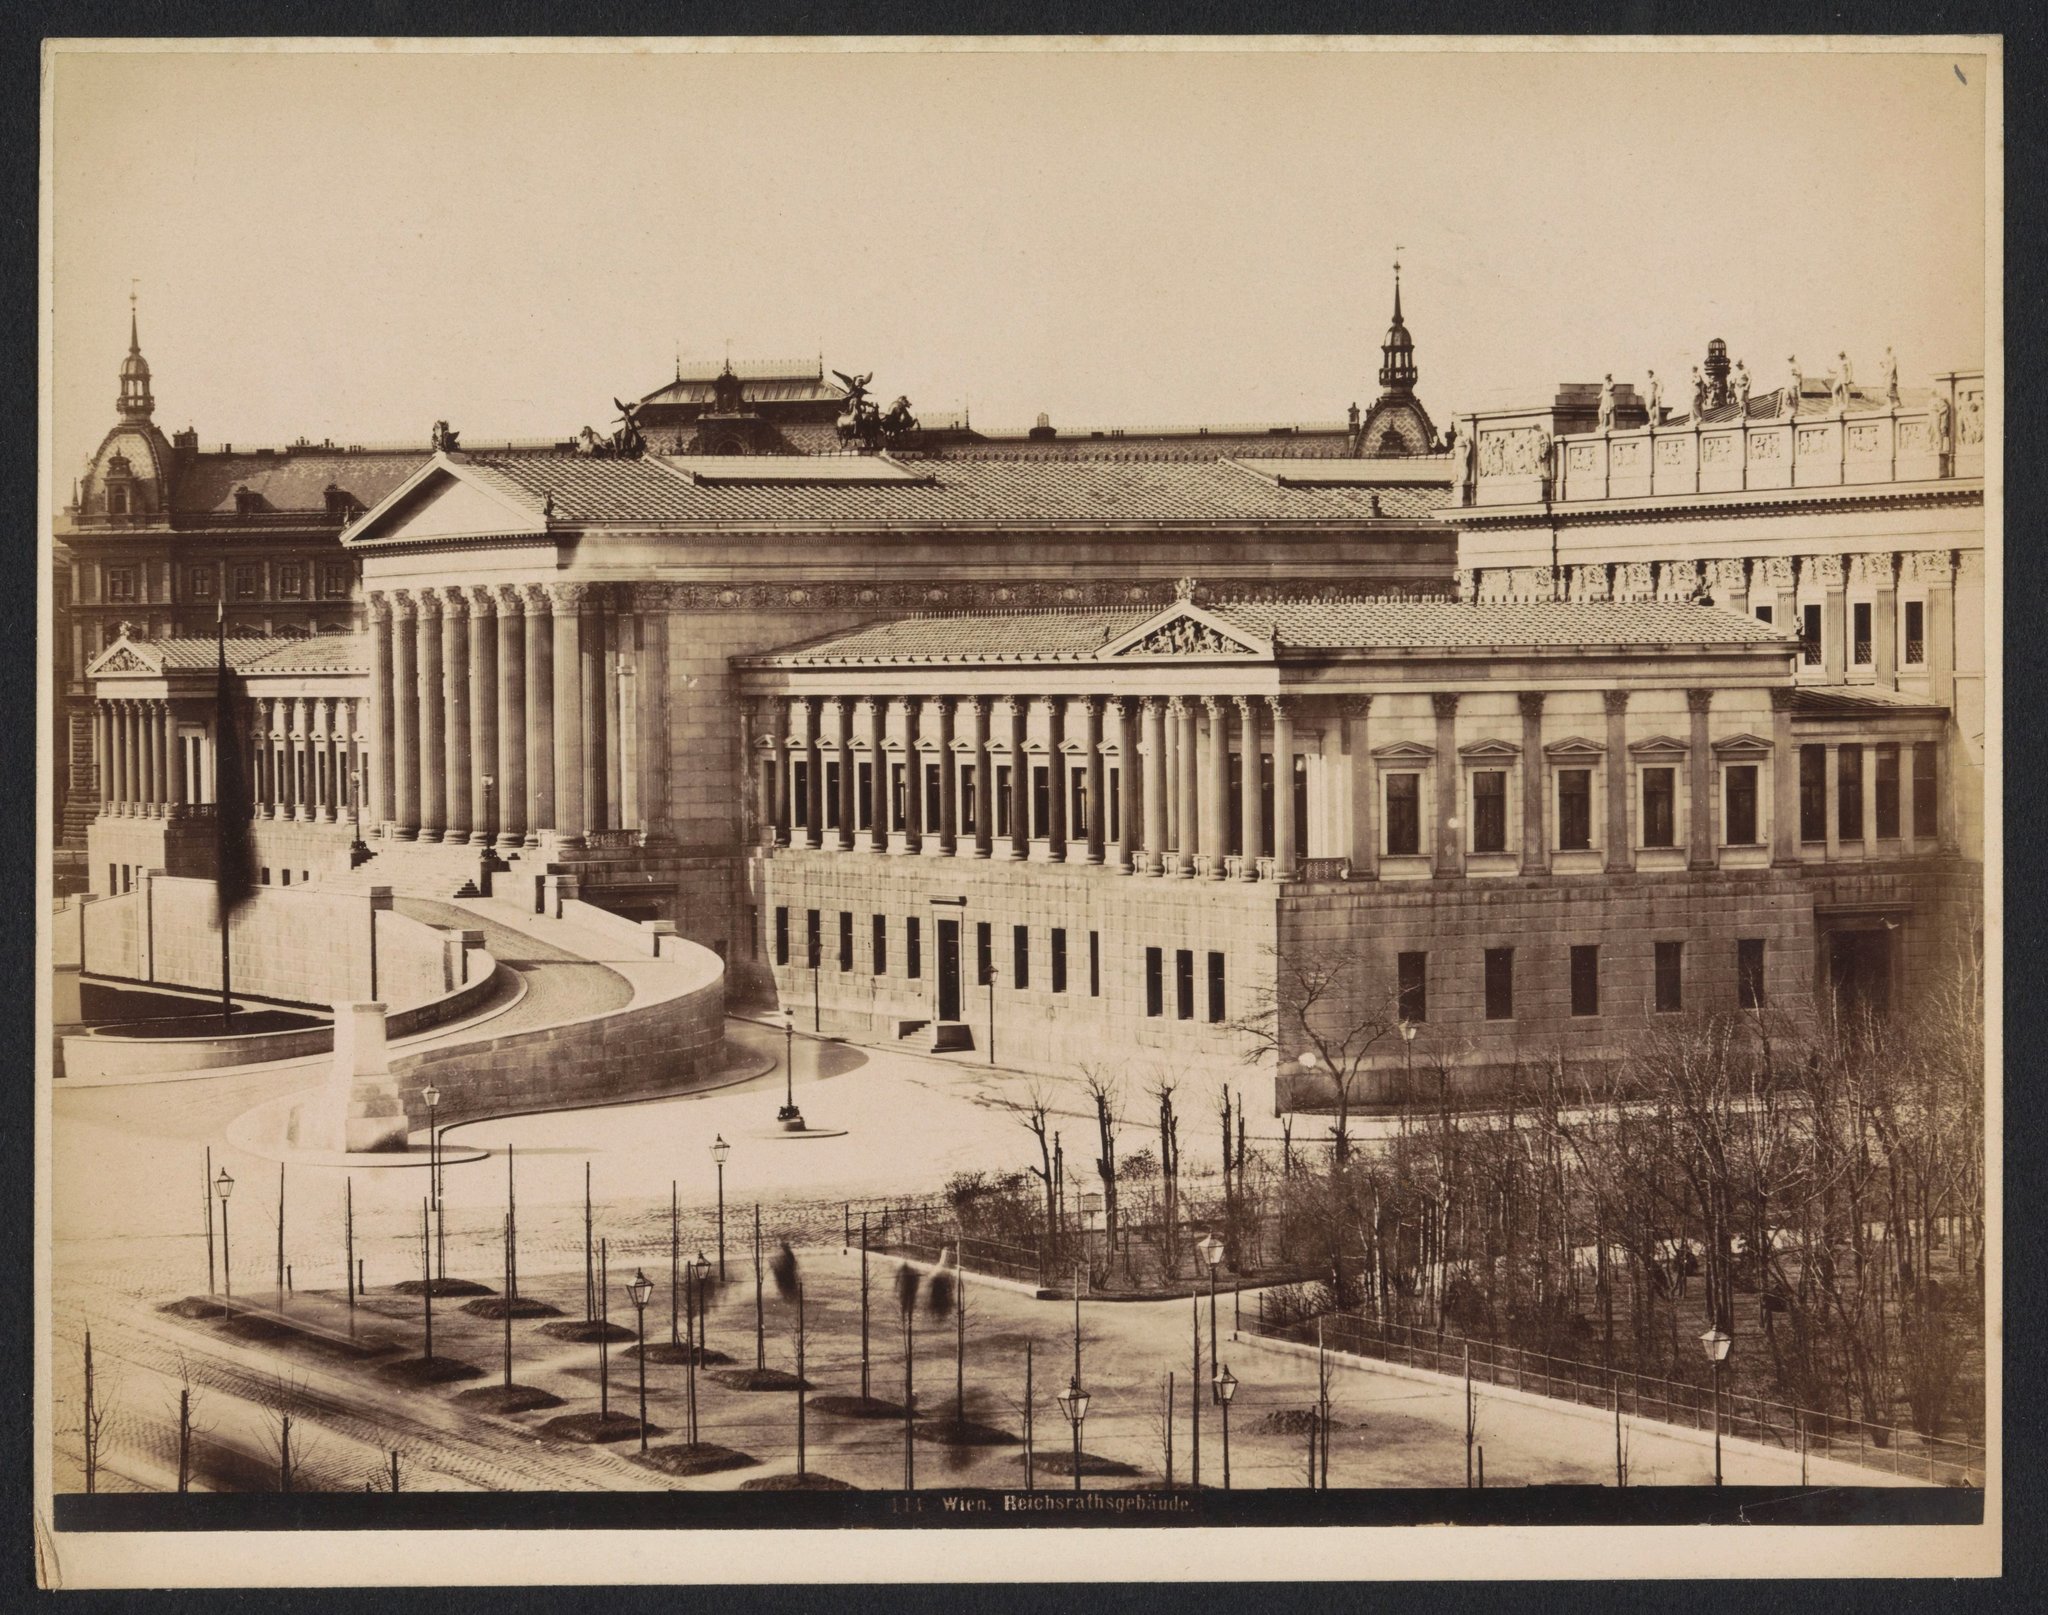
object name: photograph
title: Reichsrathsgebäude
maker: Anonymous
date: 1851-1900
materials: cardboard, paper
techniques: albumen print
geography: vienna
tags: exterior ~ representation of a building, lower house, parliament, chamber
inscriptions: number: ‘111’